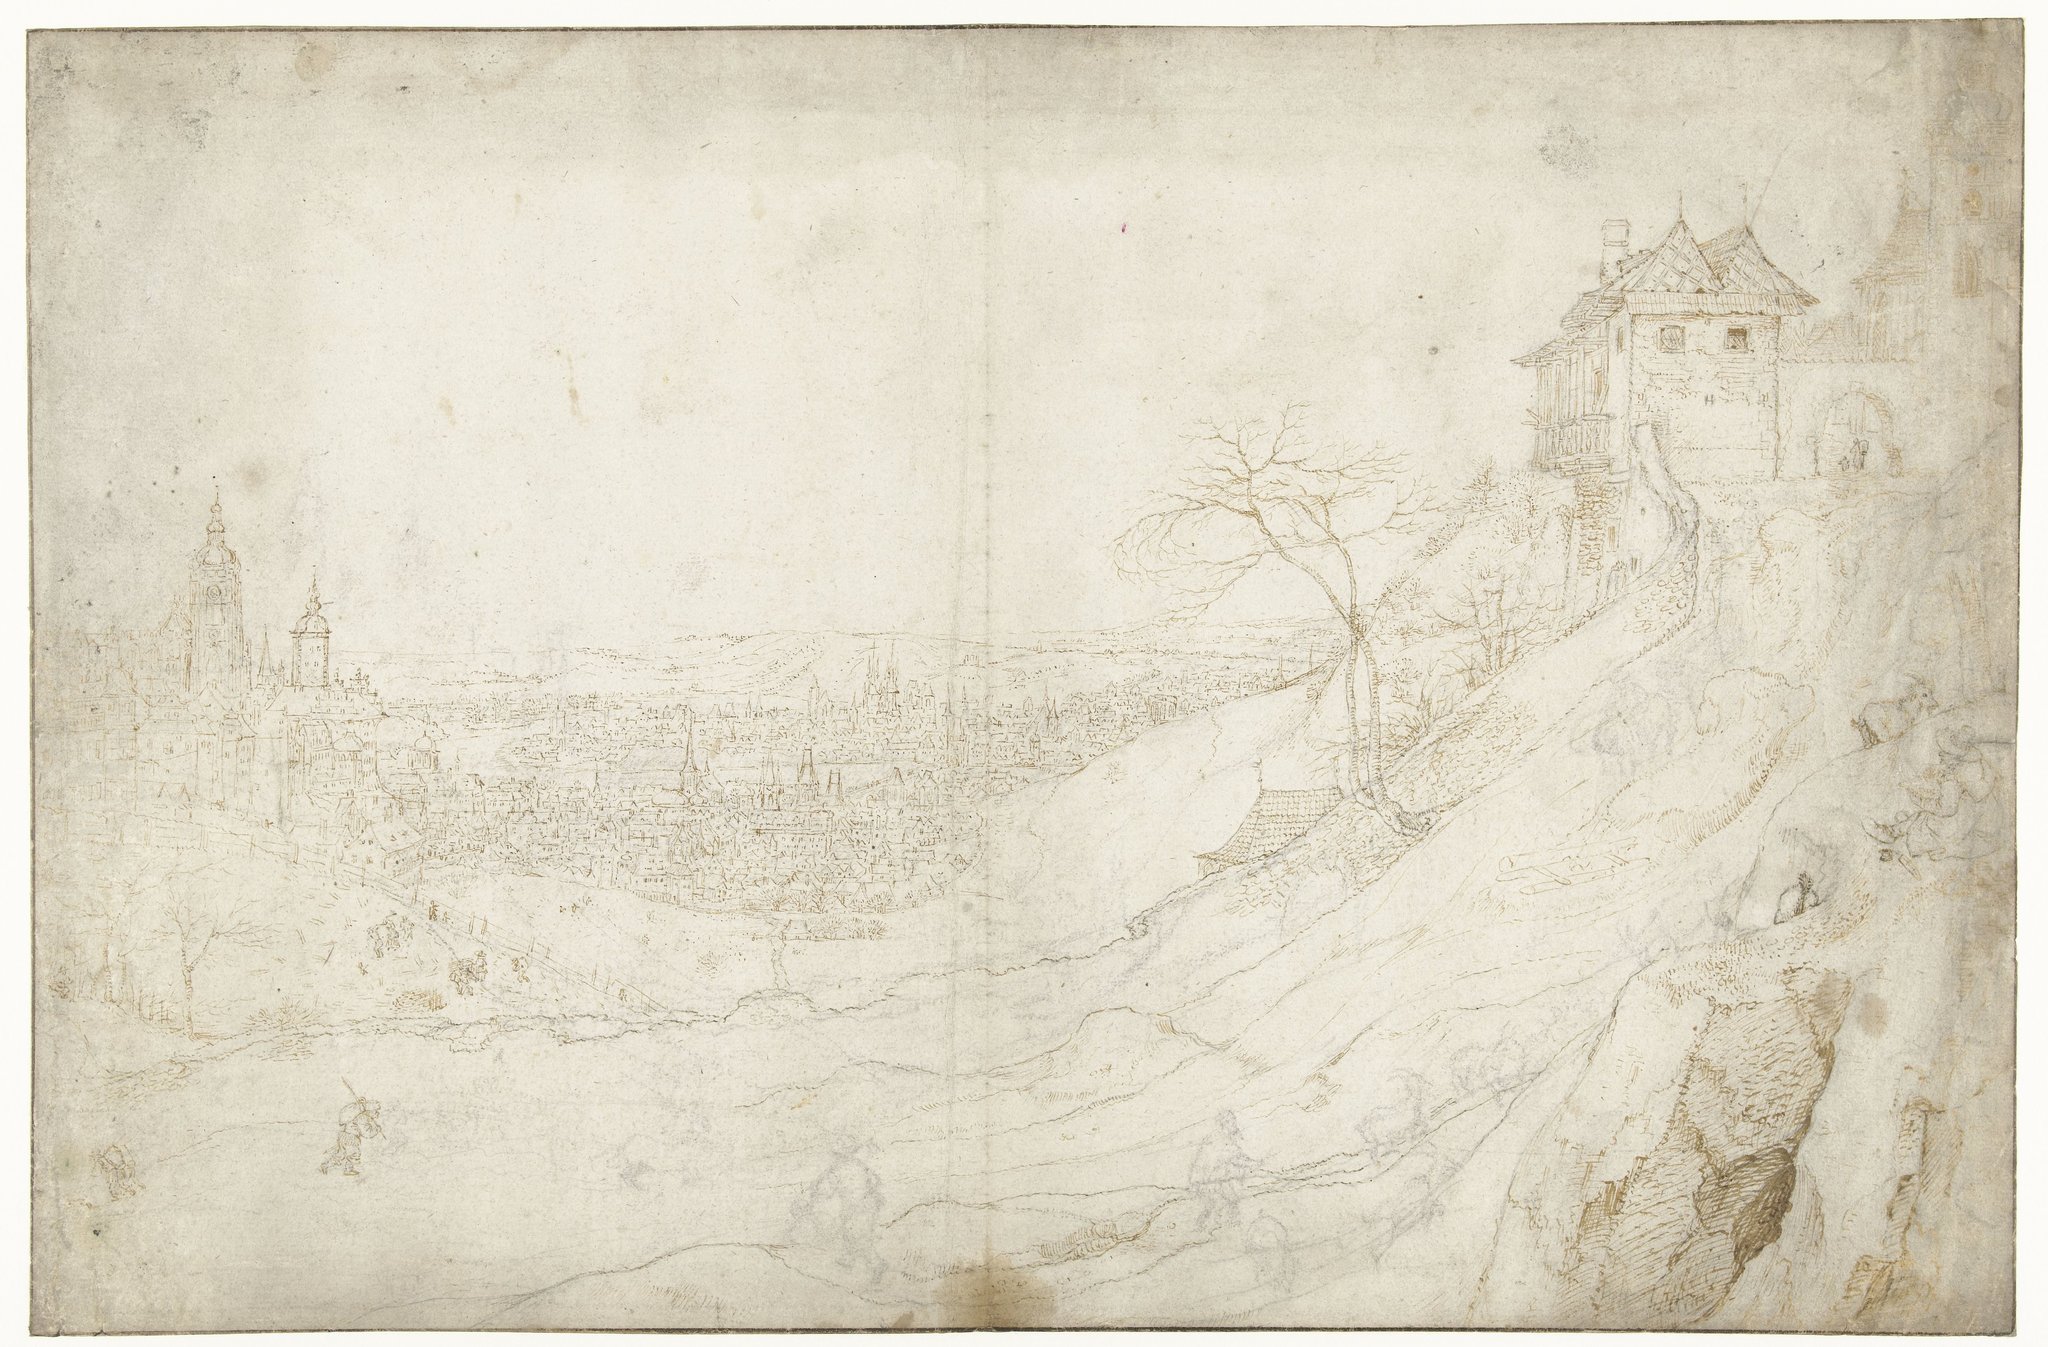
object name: drawing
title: Gezicht op Praag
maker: roelant savery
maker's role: draughtsman, painter, print maker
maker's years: 1576-1639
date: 1603-1613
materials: chalk, ink, paper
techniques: pen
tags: (high) hill, prospect of city, town panorama, silhouette of city, prague